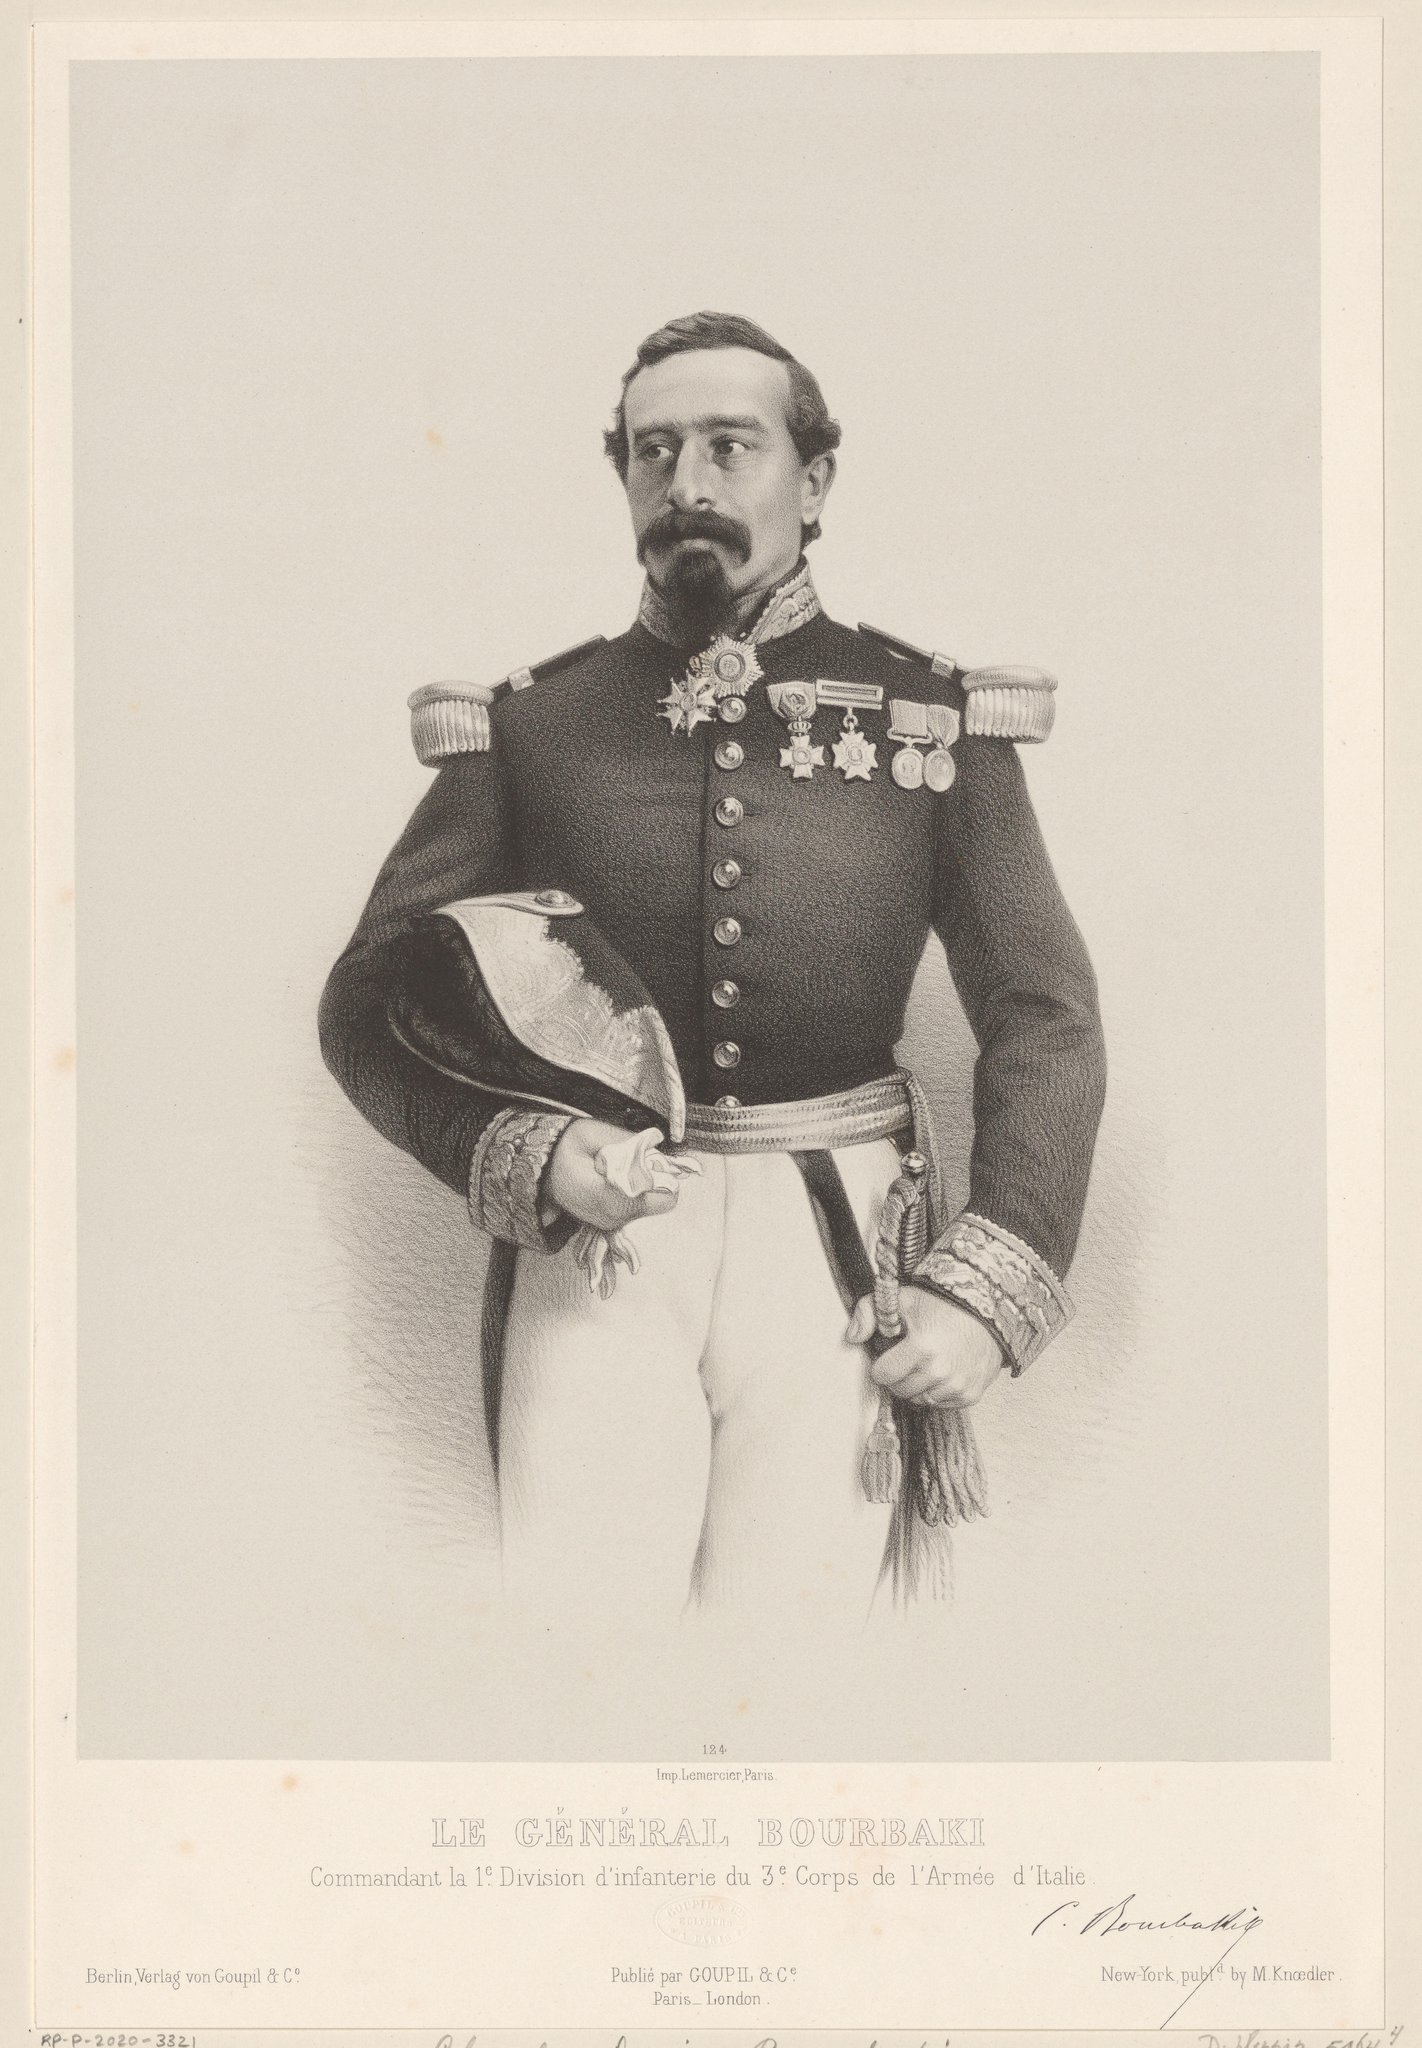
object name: print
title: Portret van Charles-Denis Bourbaki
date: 1859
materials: paper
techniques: lithograph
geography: paris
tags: commander-in-chief, general, marshal, historical persons, medals and other marks of military honour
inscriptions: workshop stamp: Lugt 1090